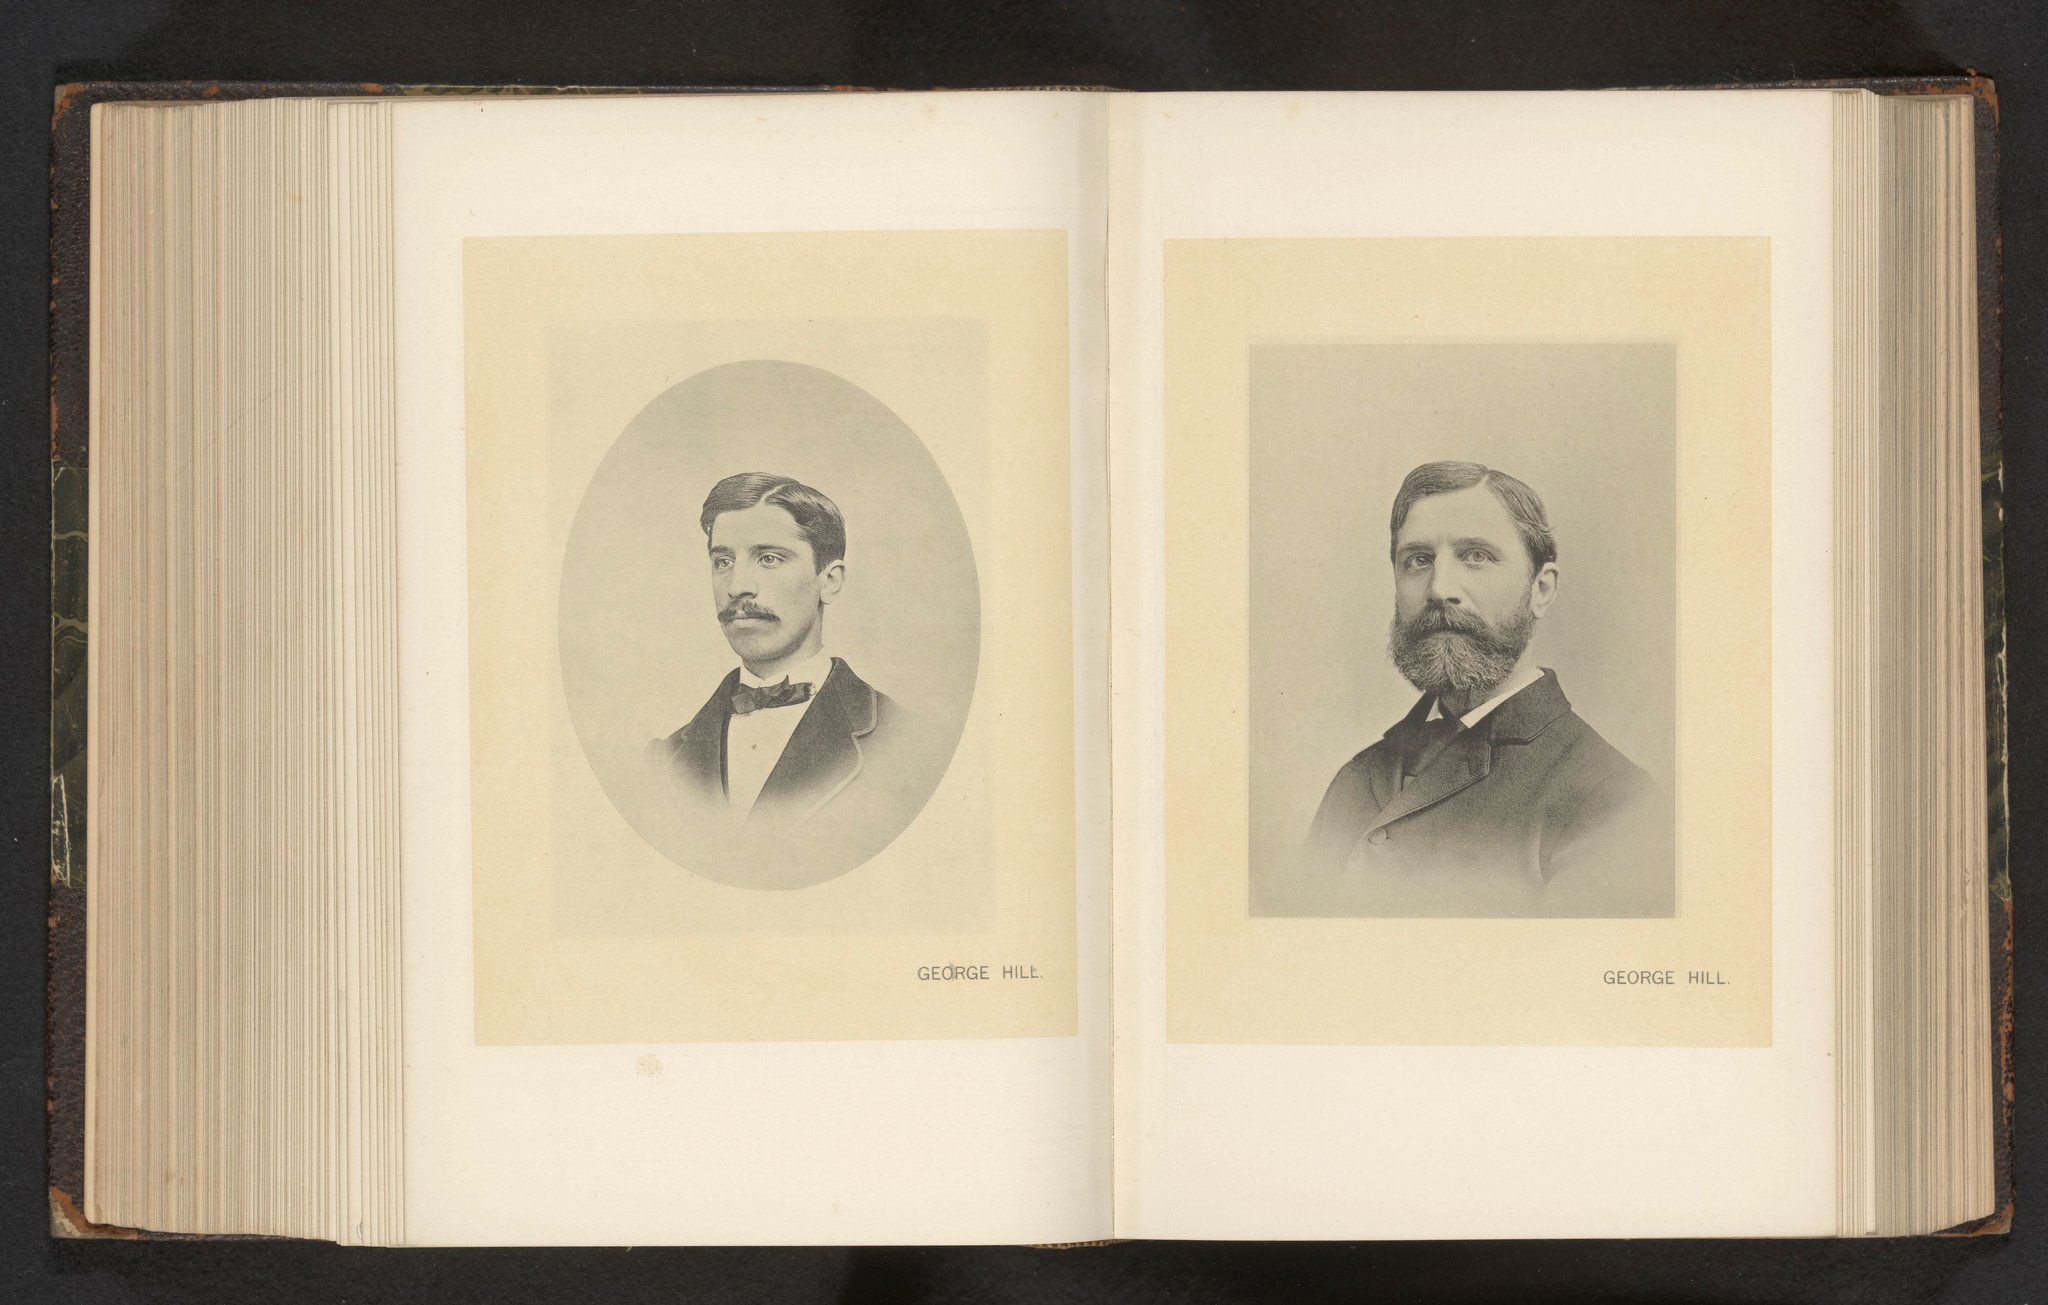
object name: photomechanical print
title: George Hill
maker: Anonymous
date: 1869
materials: paper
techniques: photoaquatint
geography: boston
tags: adult man